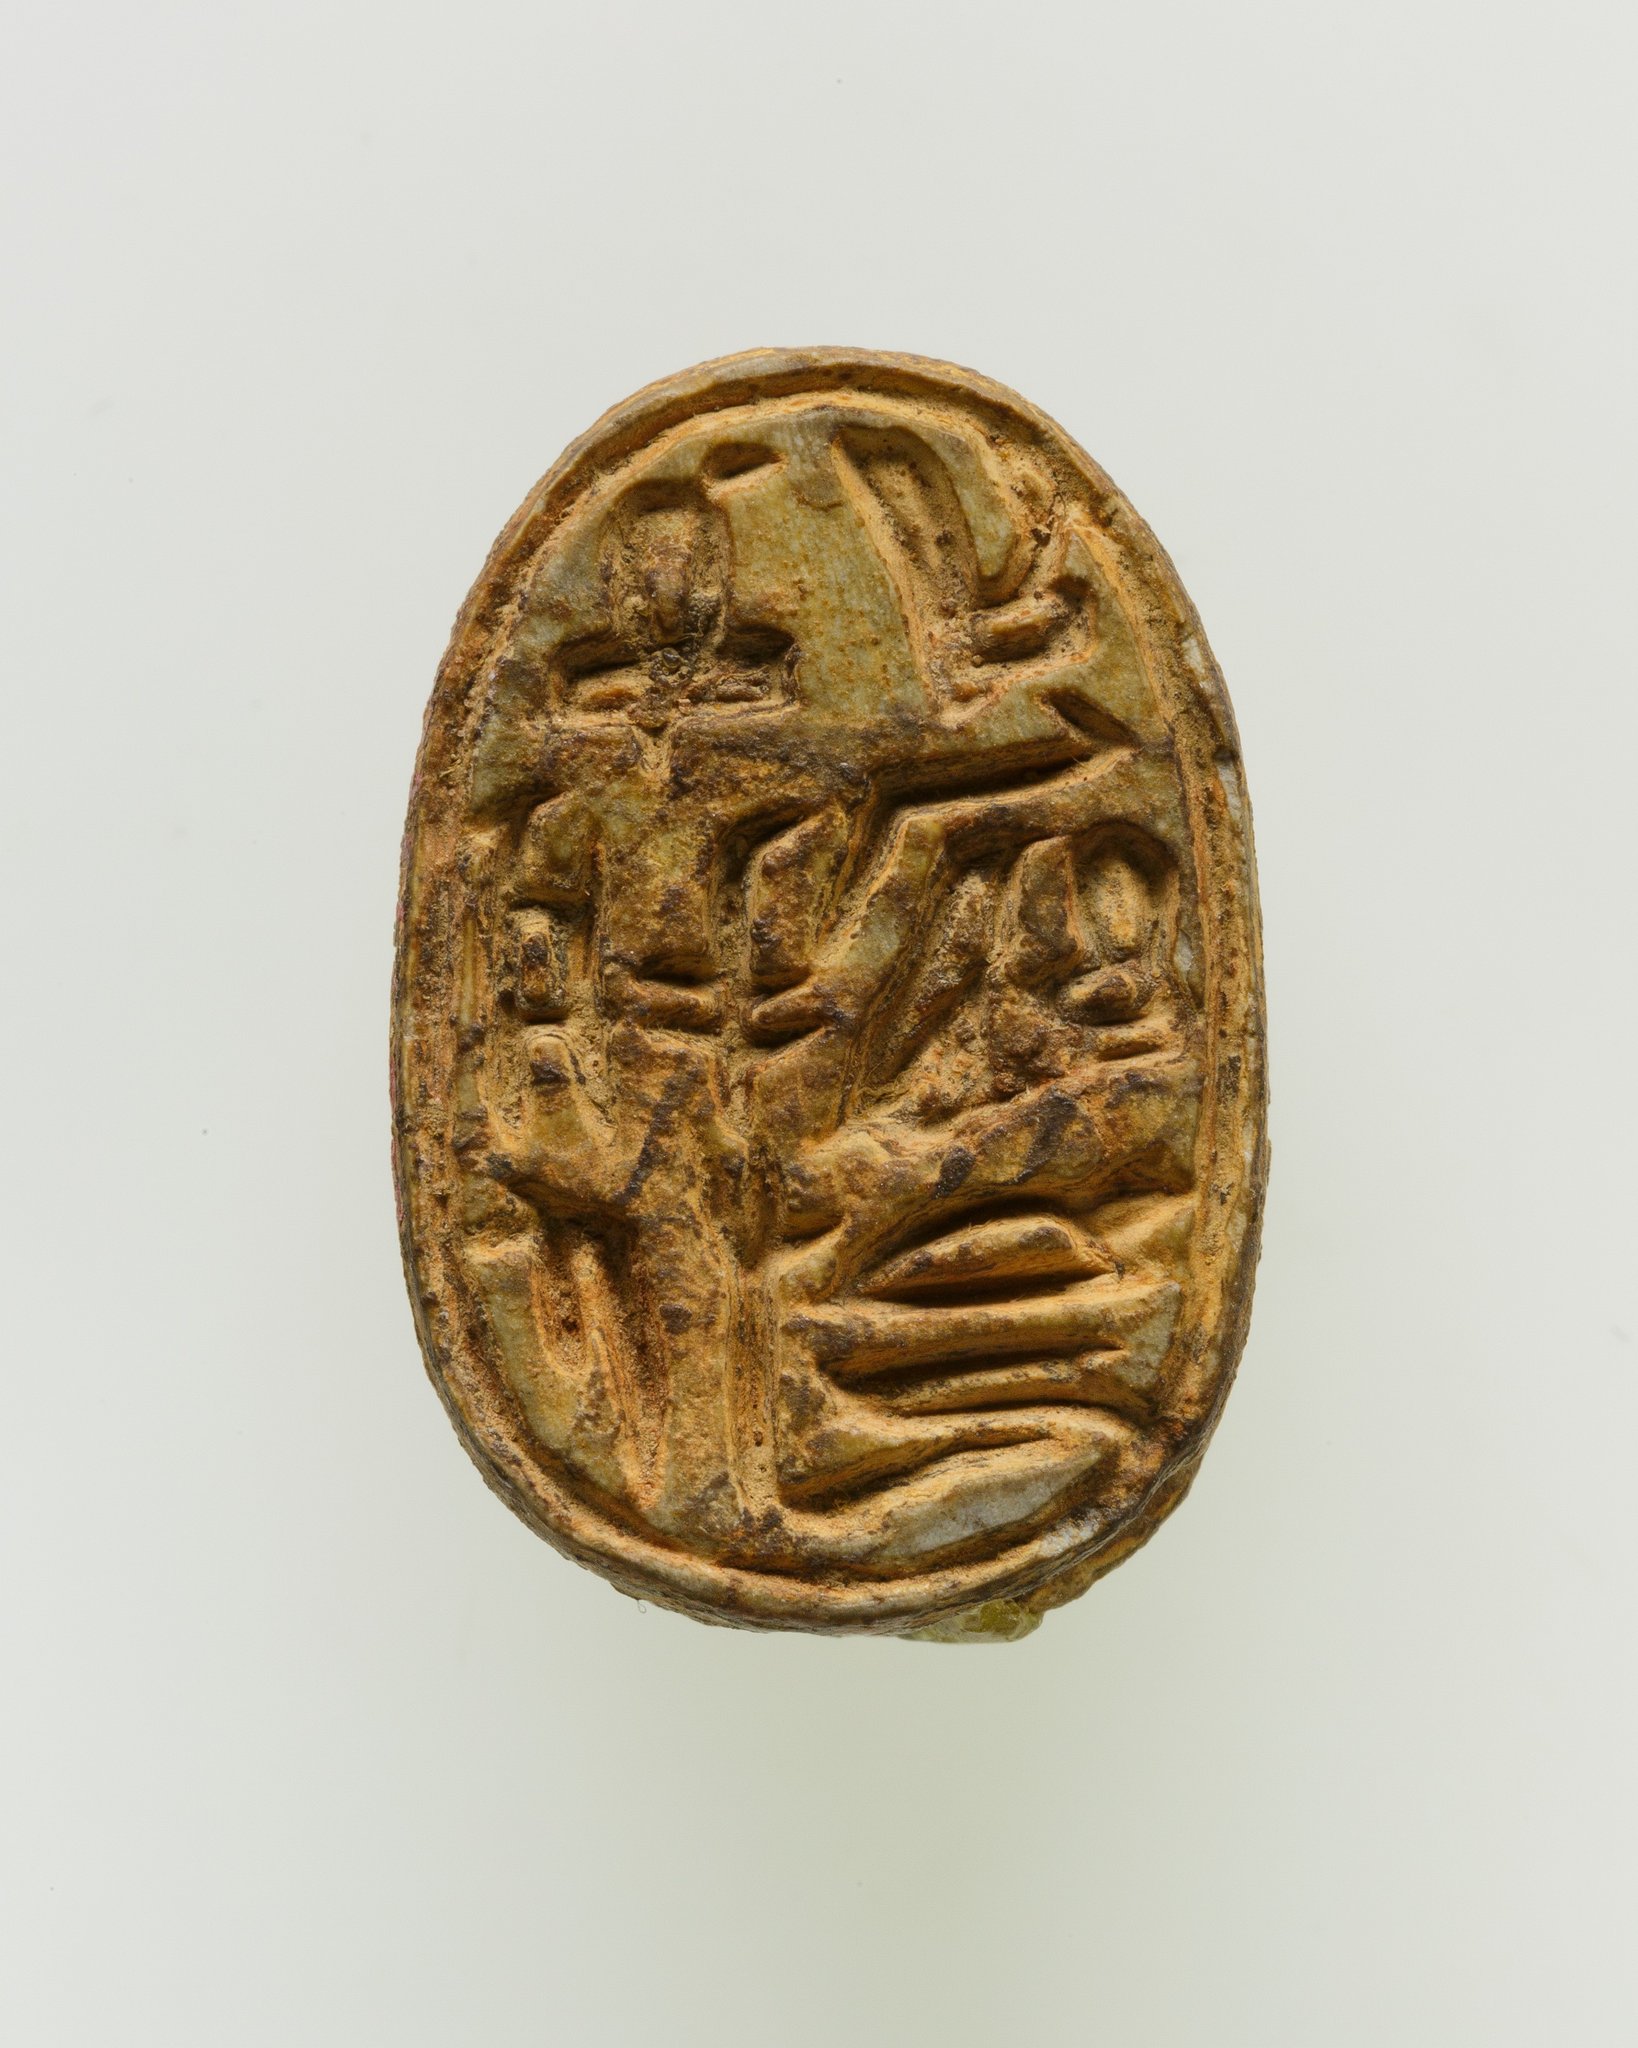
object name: scarab, official, private name and title, sebekuser, epithet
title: Scarab of an Official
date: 1760-1670 BCE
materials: stone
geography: egypt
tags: scarabs